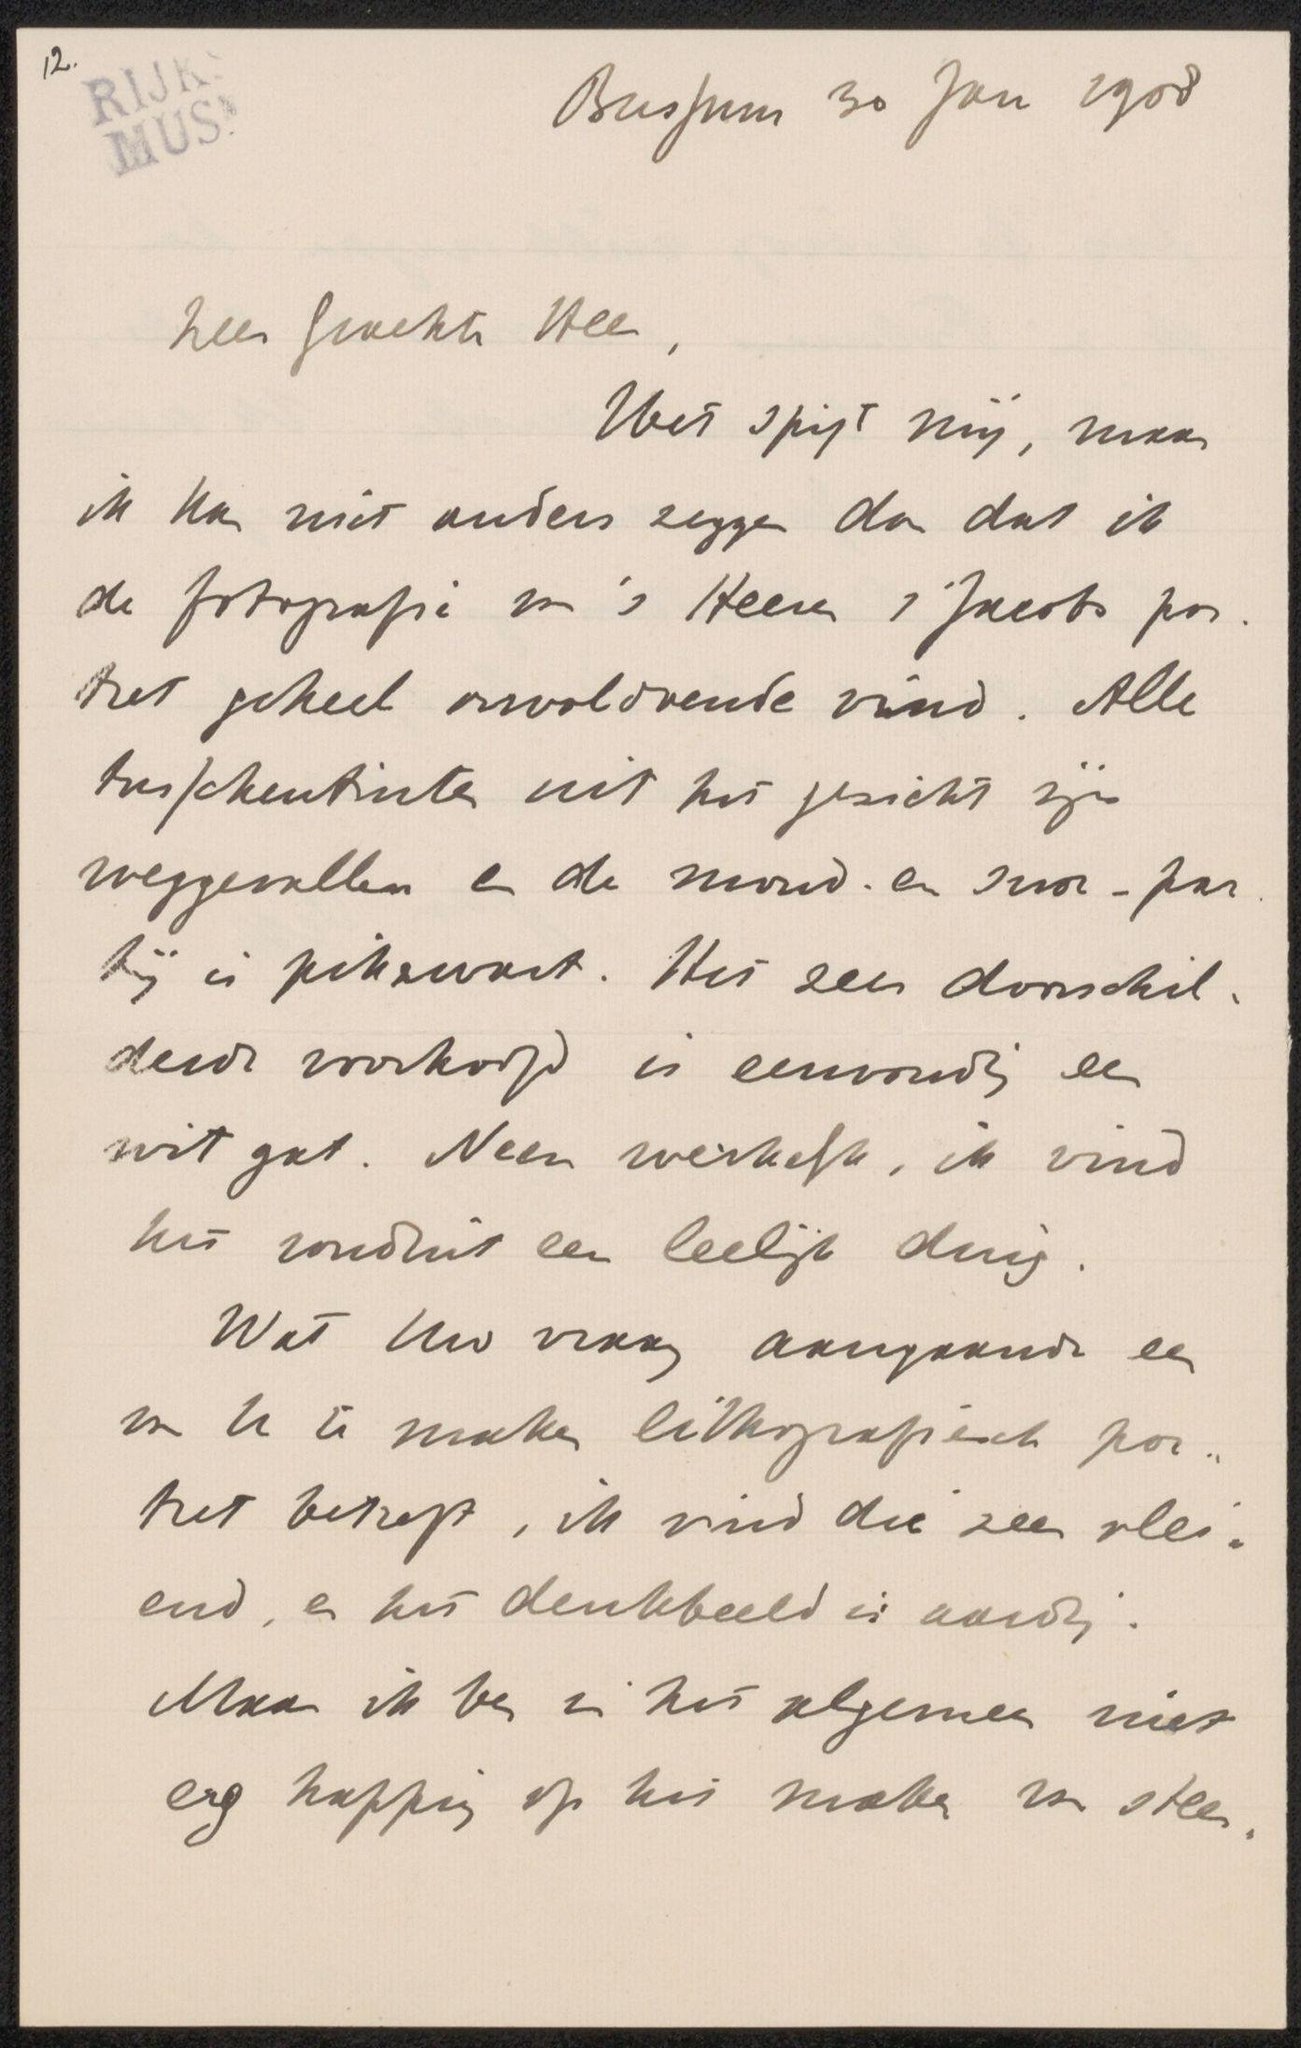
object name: letter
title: Brief aan Pieter Haverkorn van Rijsewijk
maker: jan veth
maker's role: designer, draughtsman, painter, print maker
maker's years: 1864-1925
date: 1908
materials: ink, paper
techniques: pen, writing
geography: bussum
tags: pieter haverkorn van rijsewijk, drawing, photography, cinematography, the graphic arts, historical persons (portraits and scenes from the life)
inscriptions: watermark, collector's mark: Lugt 2166